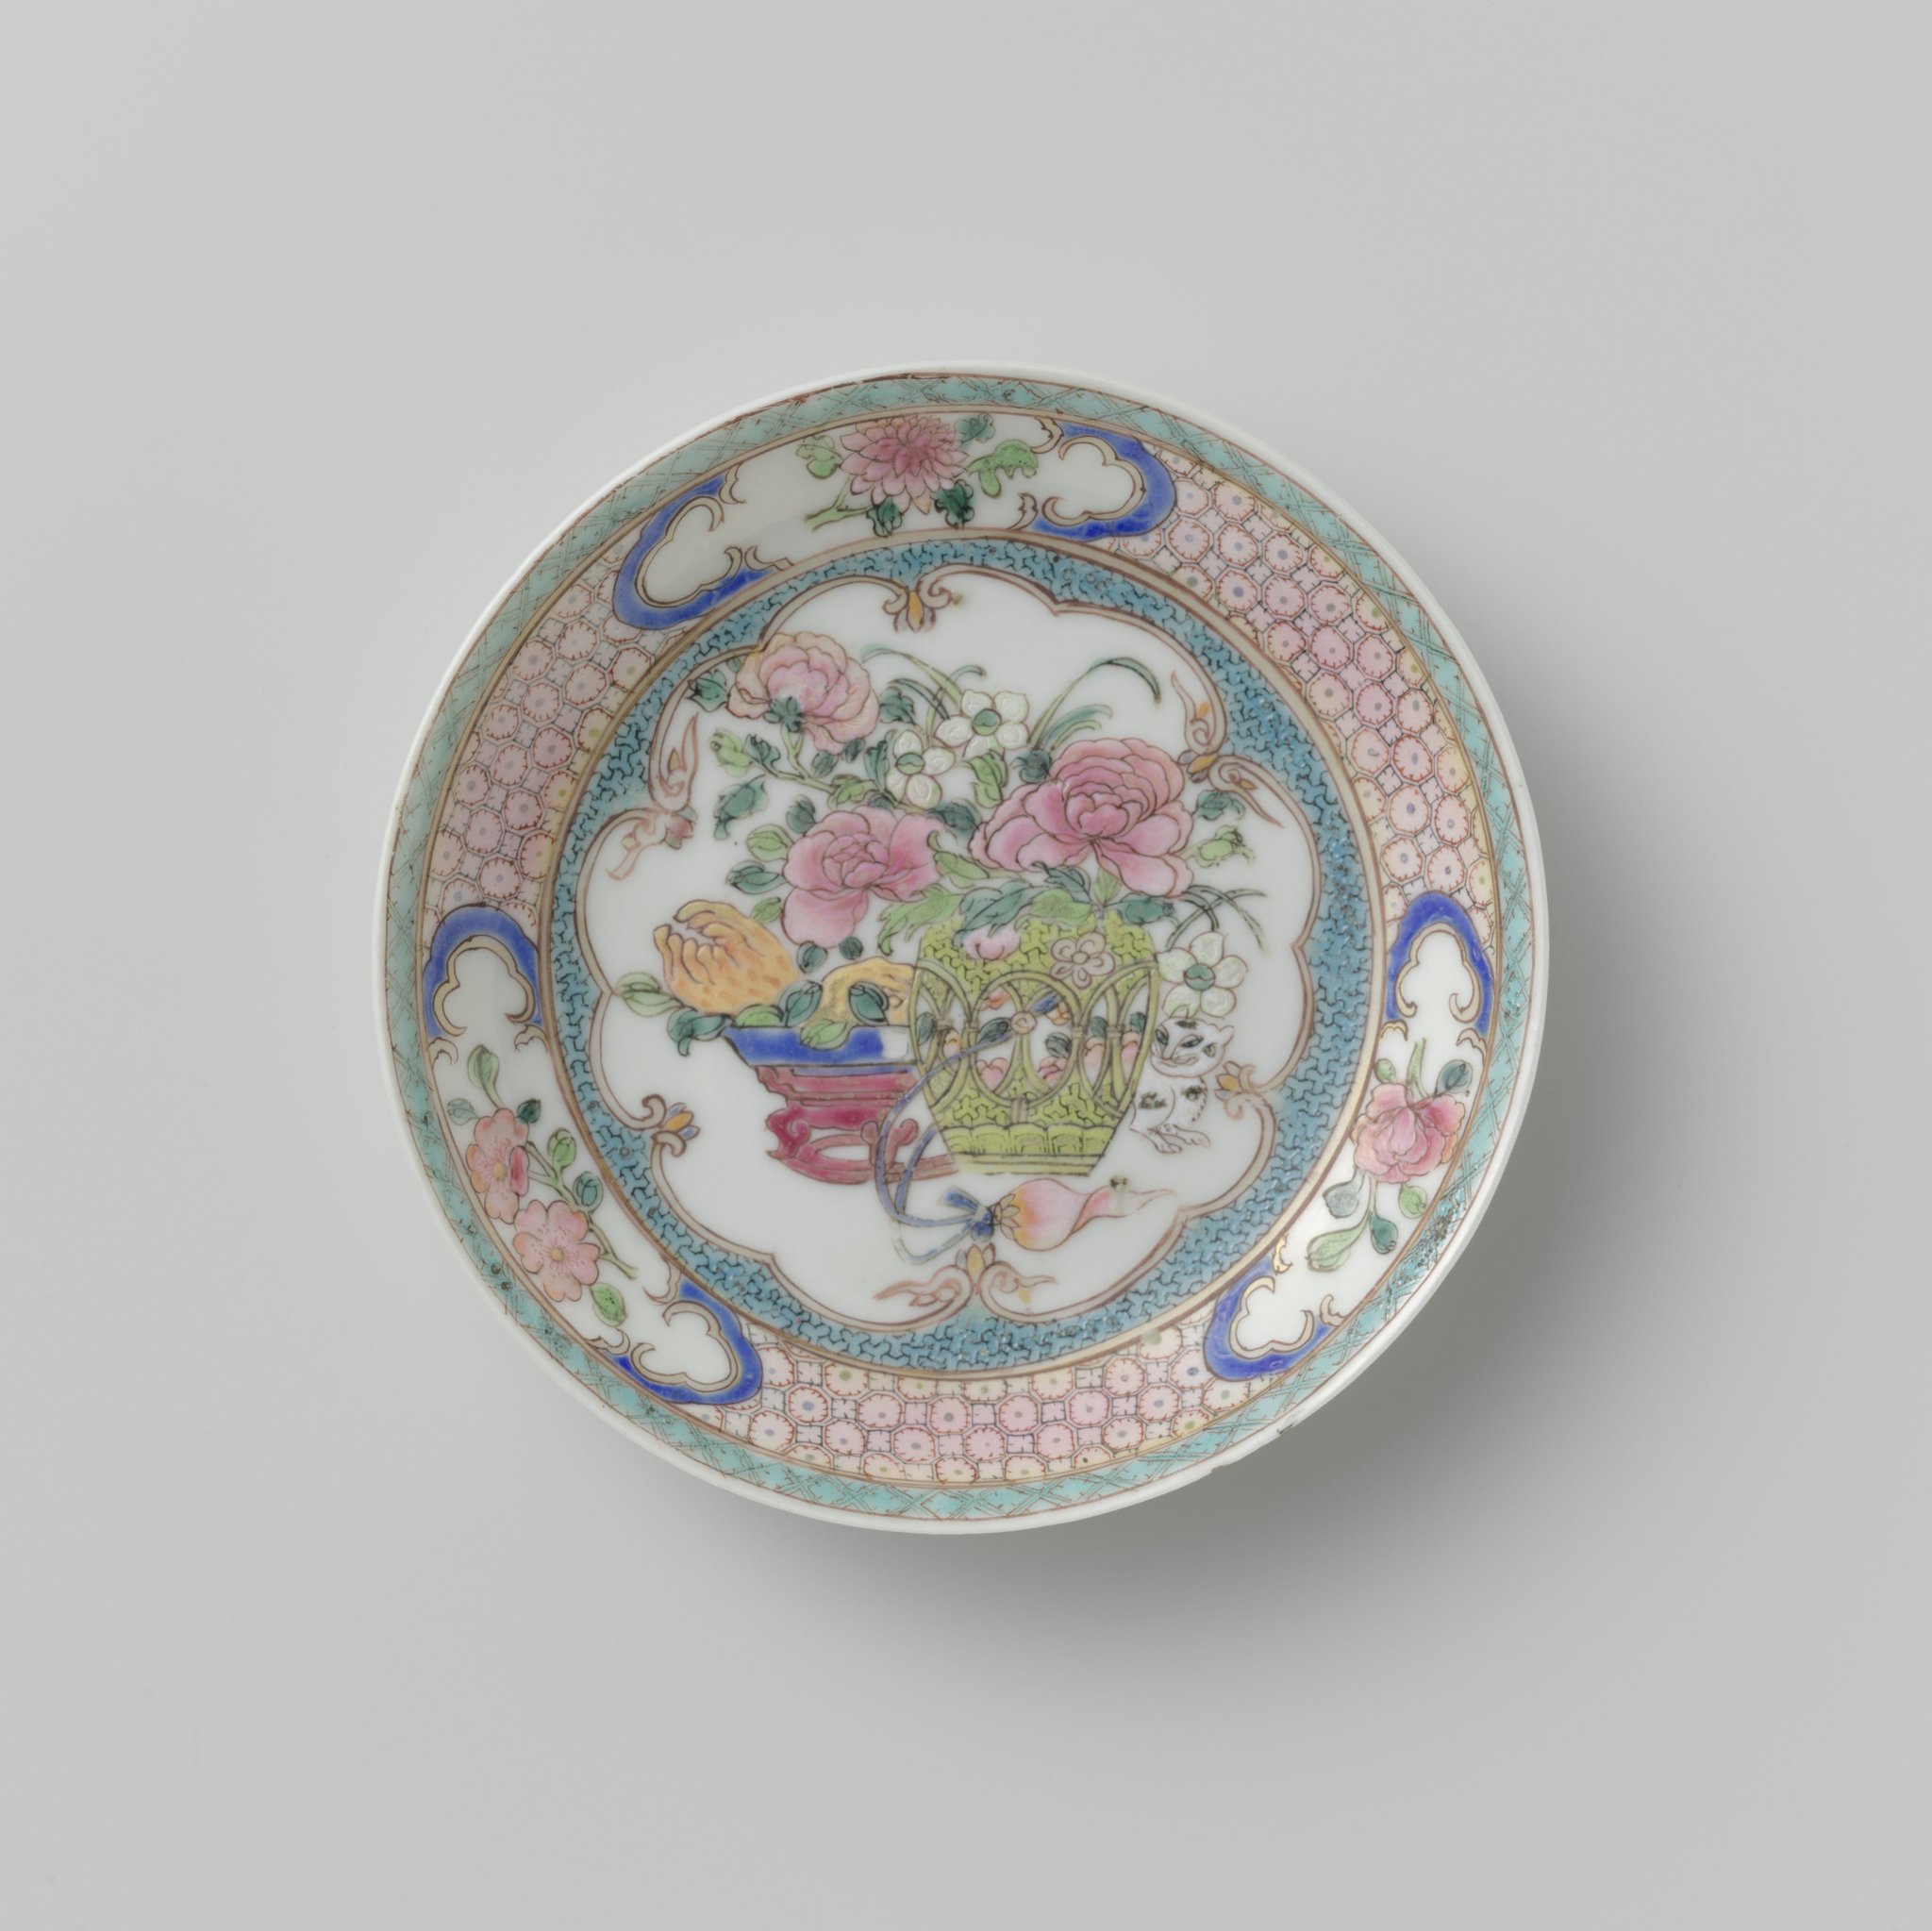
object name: platter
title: Saucer with flower and fruit basket and cat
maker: Anonymous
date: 1800-1899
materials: glaze, gold, paint, porcelain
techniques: firing, gilding, turning, vitrification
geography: china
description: Schotel van porselein, versierd met bloemvaas en bak met vruchten, in kleuren.